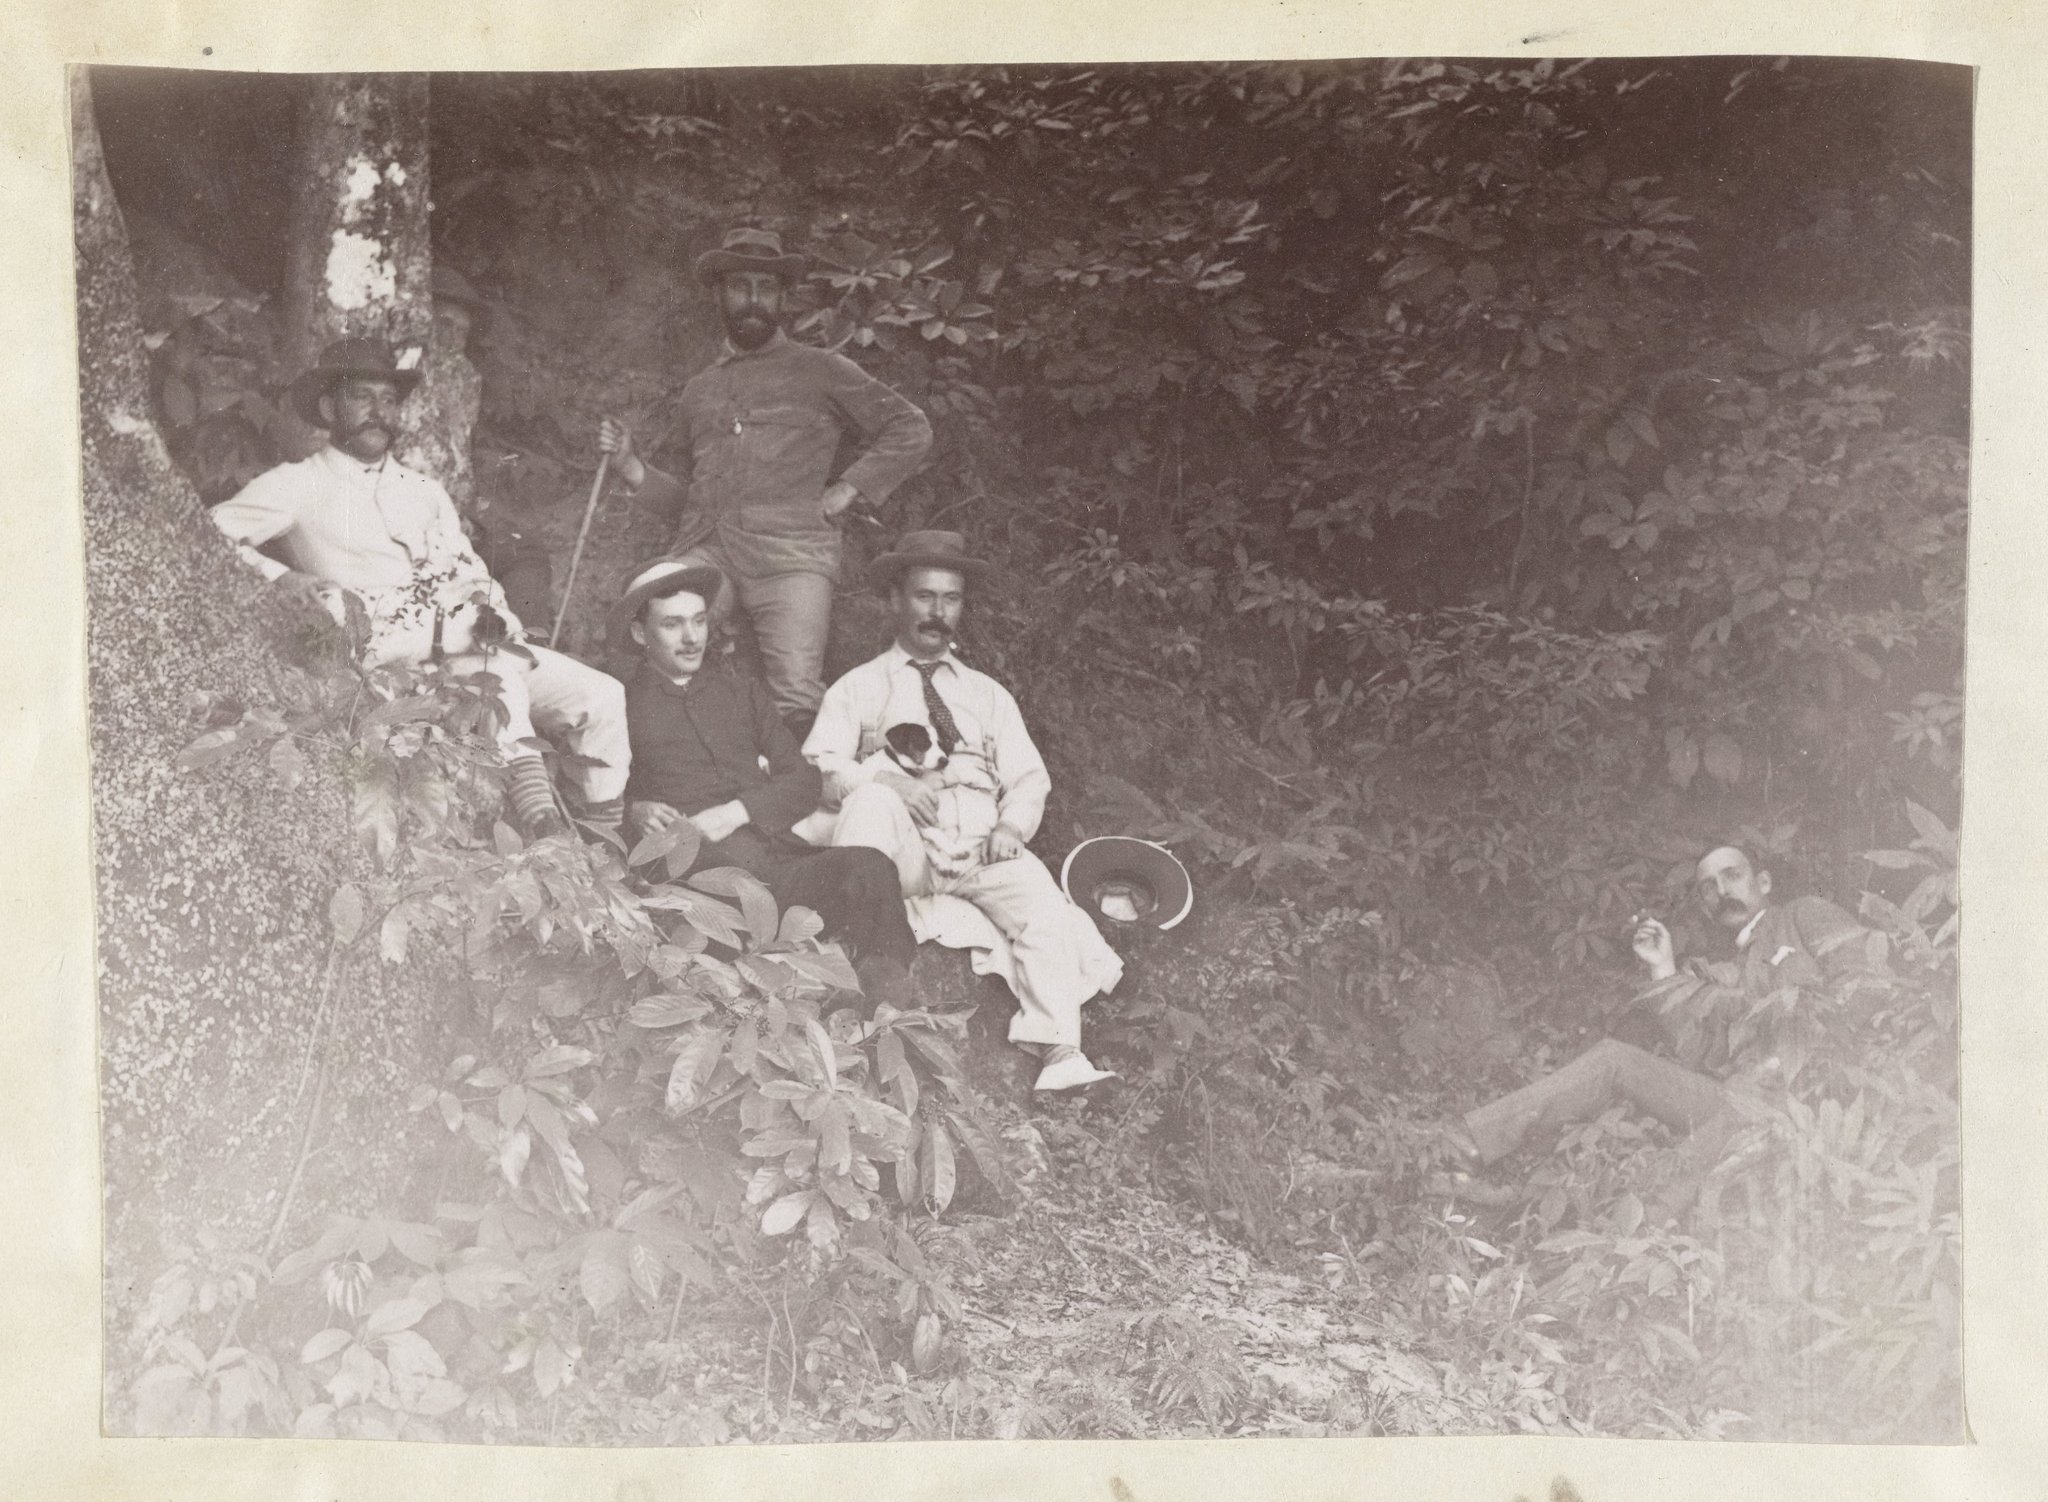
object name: album leaf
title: Groepsportret van vijf mannen in een bos, China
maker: Anonymous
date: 1879-1890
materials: paper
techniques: albumen print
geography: china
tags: forest, wood, outdoor gathering, 'délices à la campagne', china